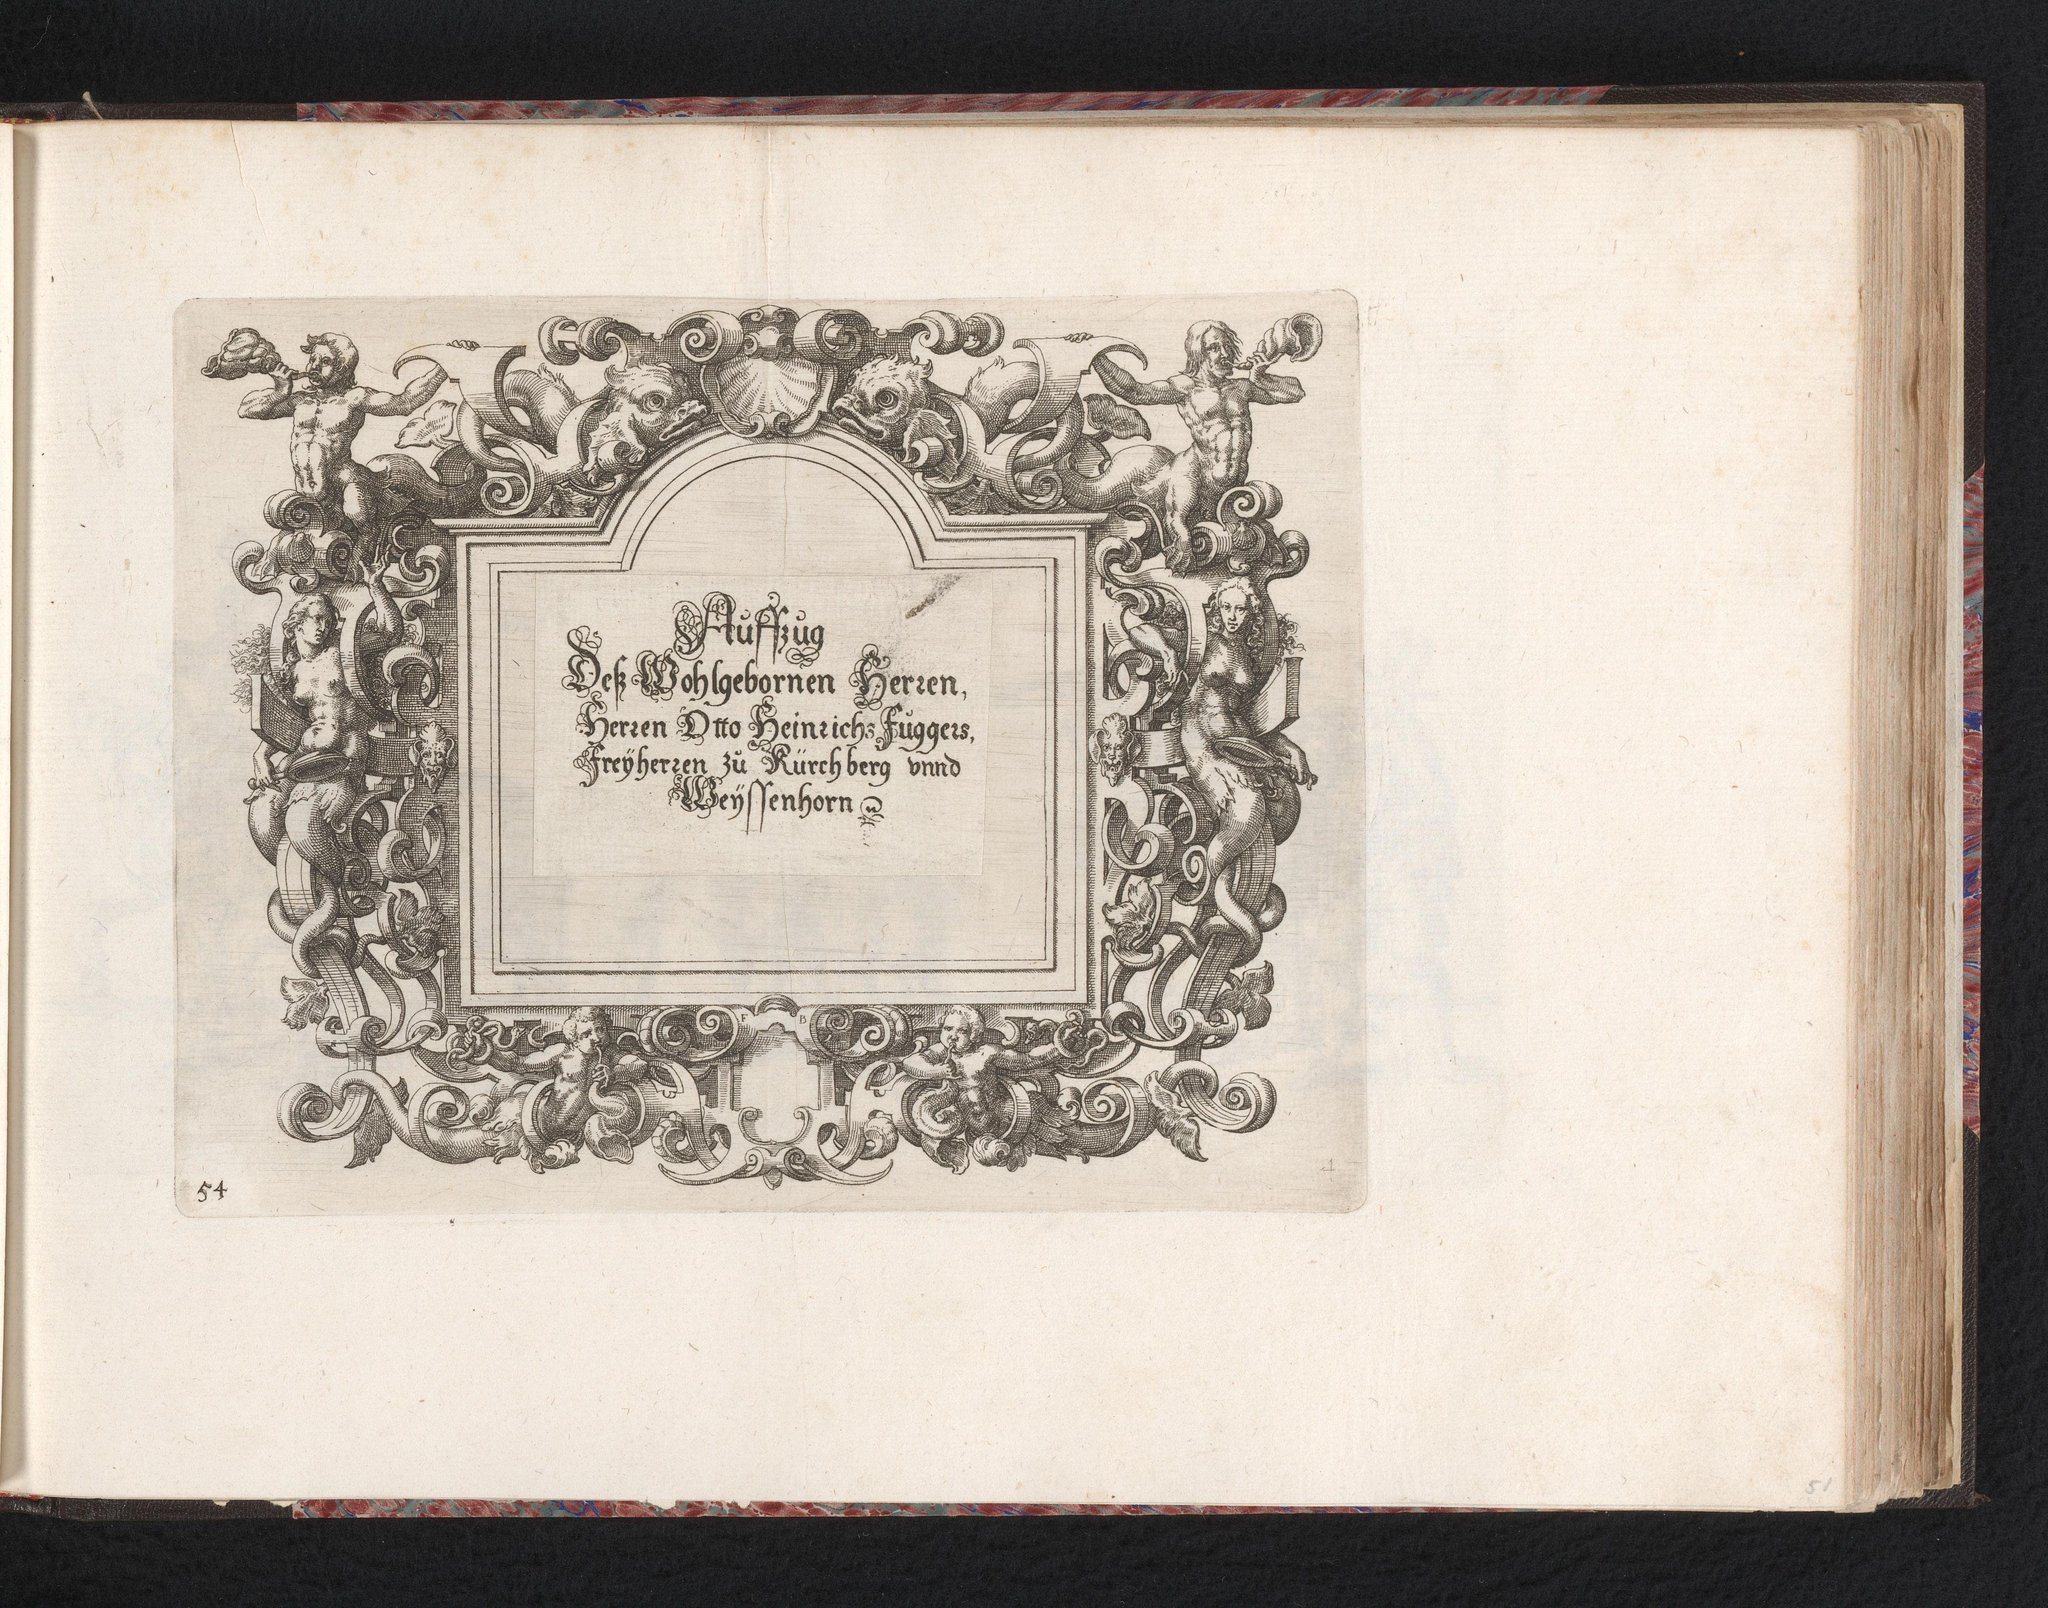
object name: album leaf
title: Aigentliche wahrhaffte Delineation unnd Abbildung aller fürstlichen Auffzüg und Rütterspilen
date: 1618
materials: paper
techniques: etching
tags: performance in the open air (pleasure fair), horses (circus performance)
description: Genummerd: 53. Deze prent maakt deel uit van een album.